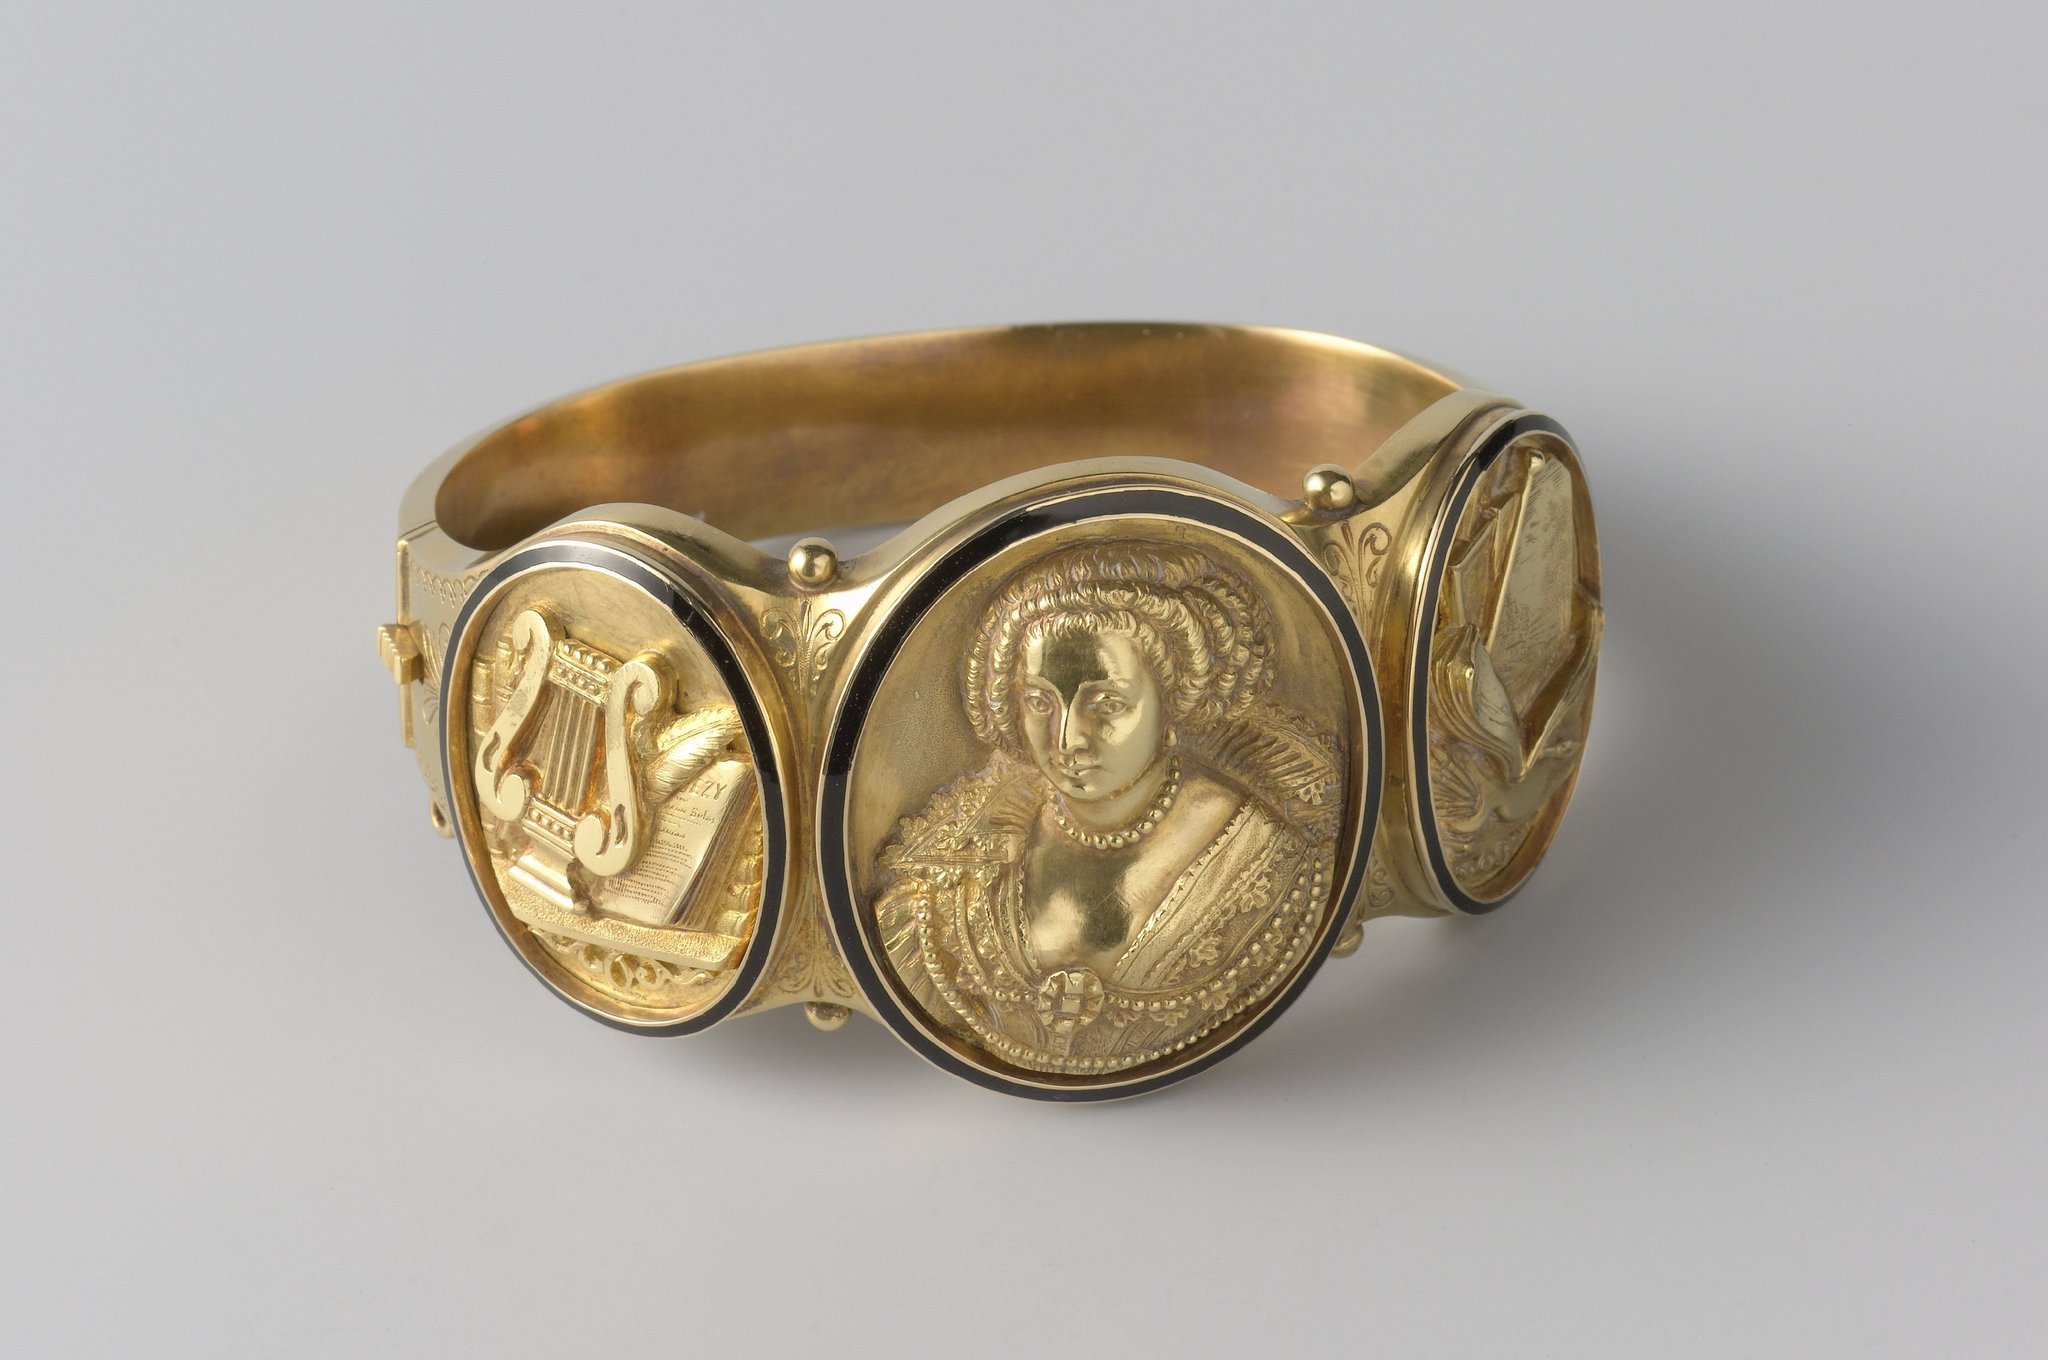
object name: jewellery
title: Parure (set of matching jewellery)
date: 1854-1858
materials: gold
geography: voorschoten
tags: the hague, amalia of solms-braunfels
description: The writer and journalist E.J. Potgieter was among the first in the 19th century to devote attention to women from the past. He commissioned this jewellery set as a gift for a relative. The seven depicted Dutch women symbolize decisiveness and fortitude. Potgieter believed his lethargic countrymen could learn a lesson from them. The medallion contains a photograph of Potgieter and a lock of his hair.